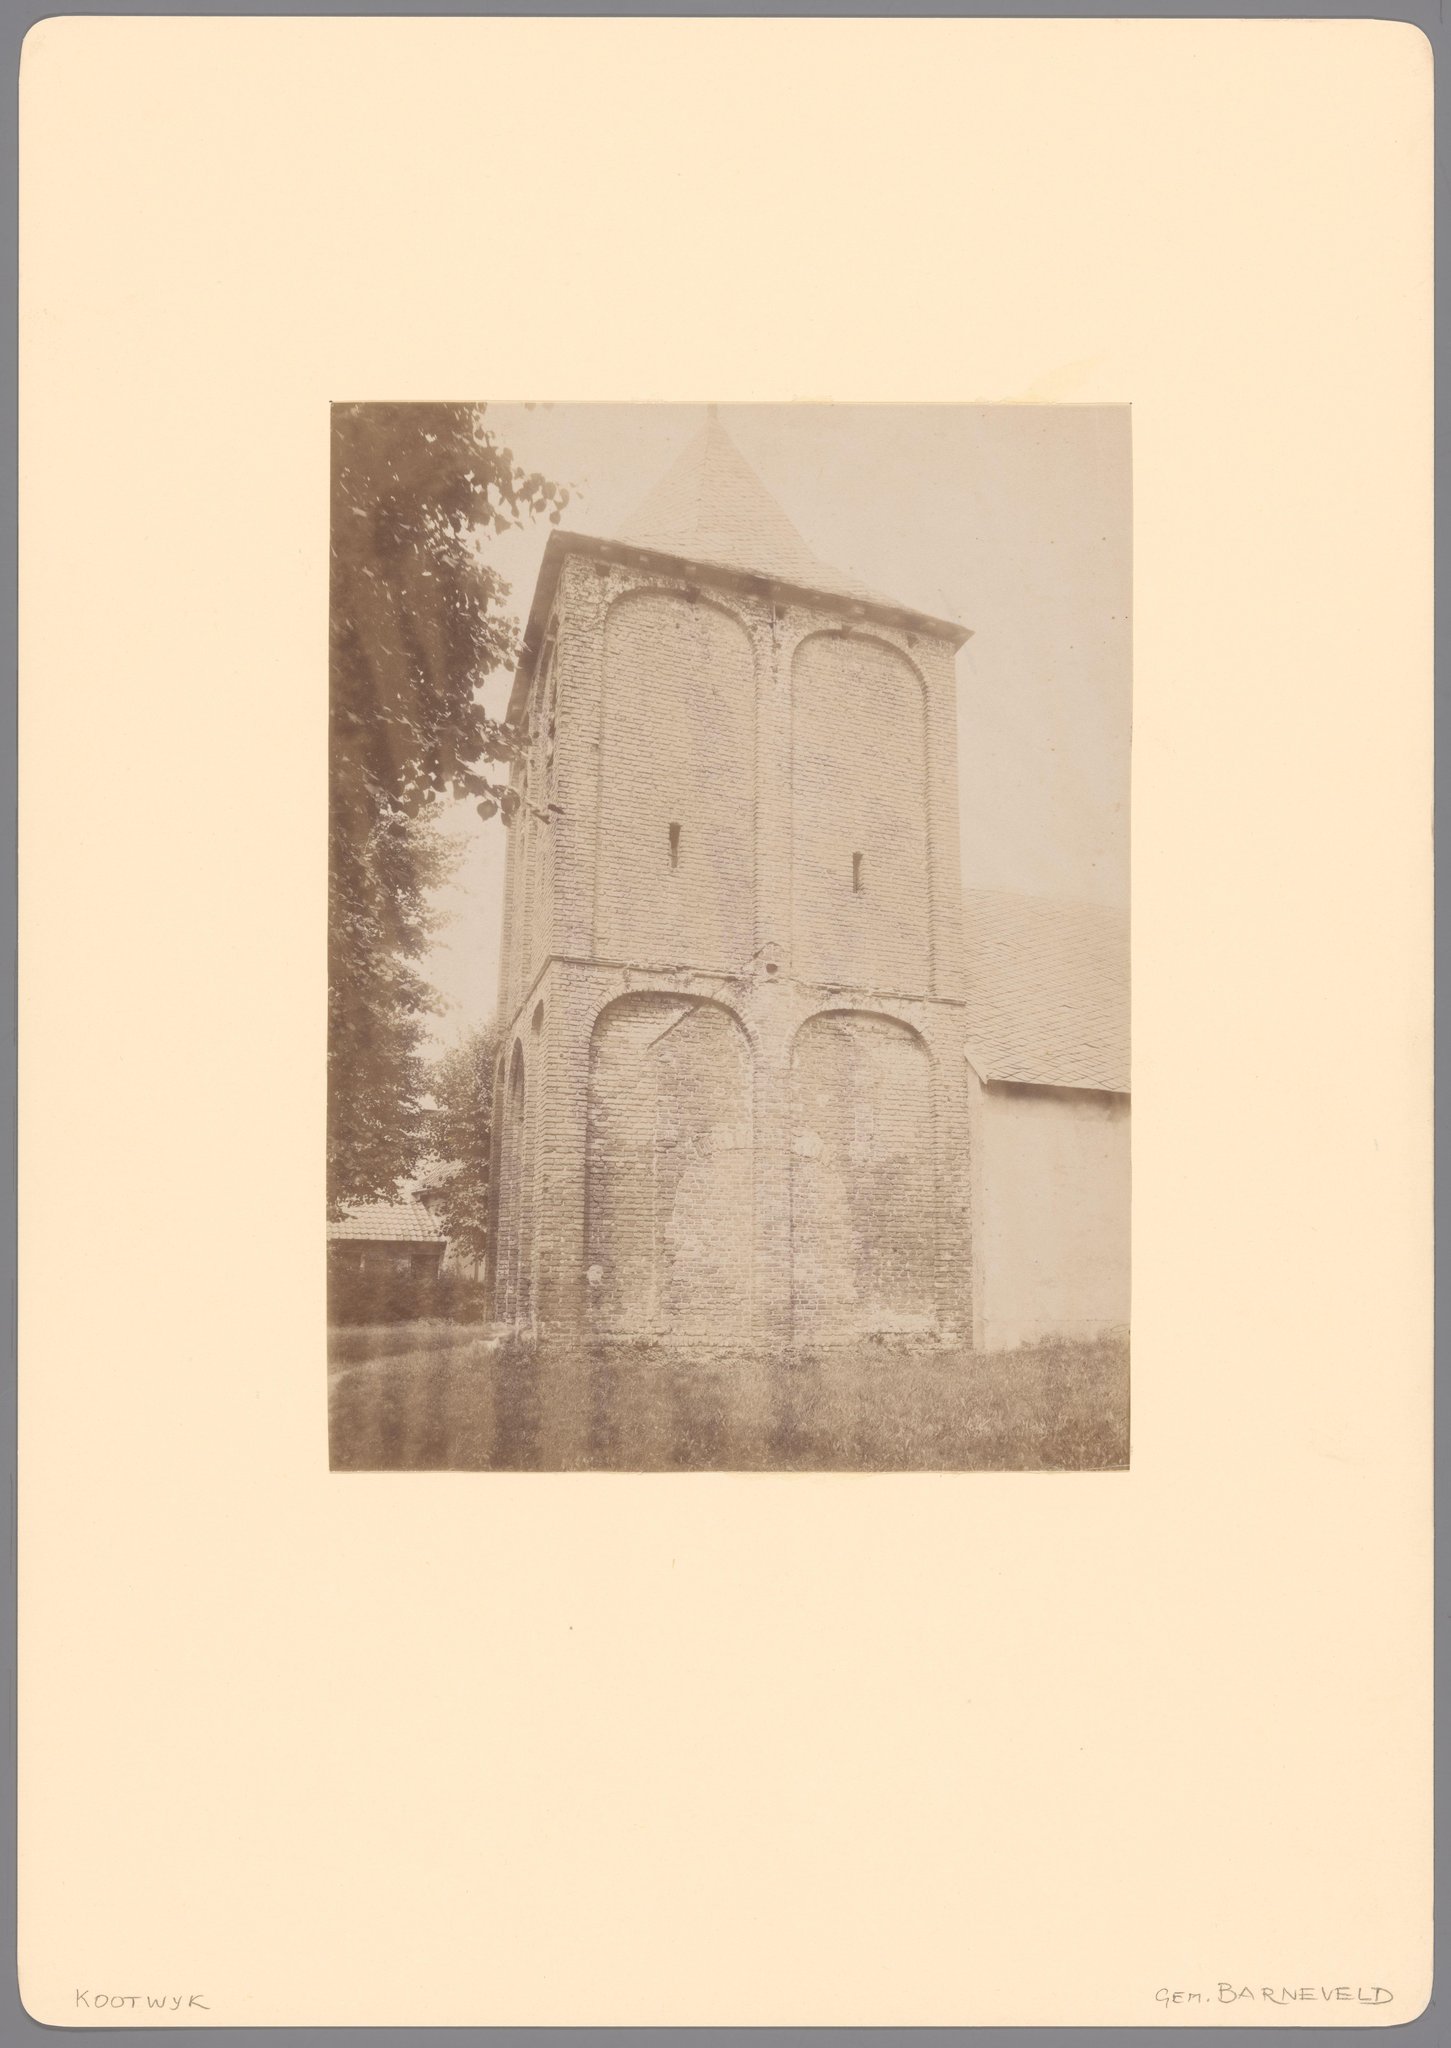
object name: photograph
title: Toren van de Hervormde Kerk te Kootwijk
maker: anoniem (monumentenzorg)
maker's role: fotograaf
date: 1903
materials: cardboard, photographic support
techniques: albumen print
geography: kootwijk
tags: parts of church exterior and annexes: tower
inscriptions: annotation: ‘Kootwijk veluwe (G.)/ Toren v/d N.H. Kerk’, annotation: ‘Kootwijk/ gem. Barneveld’